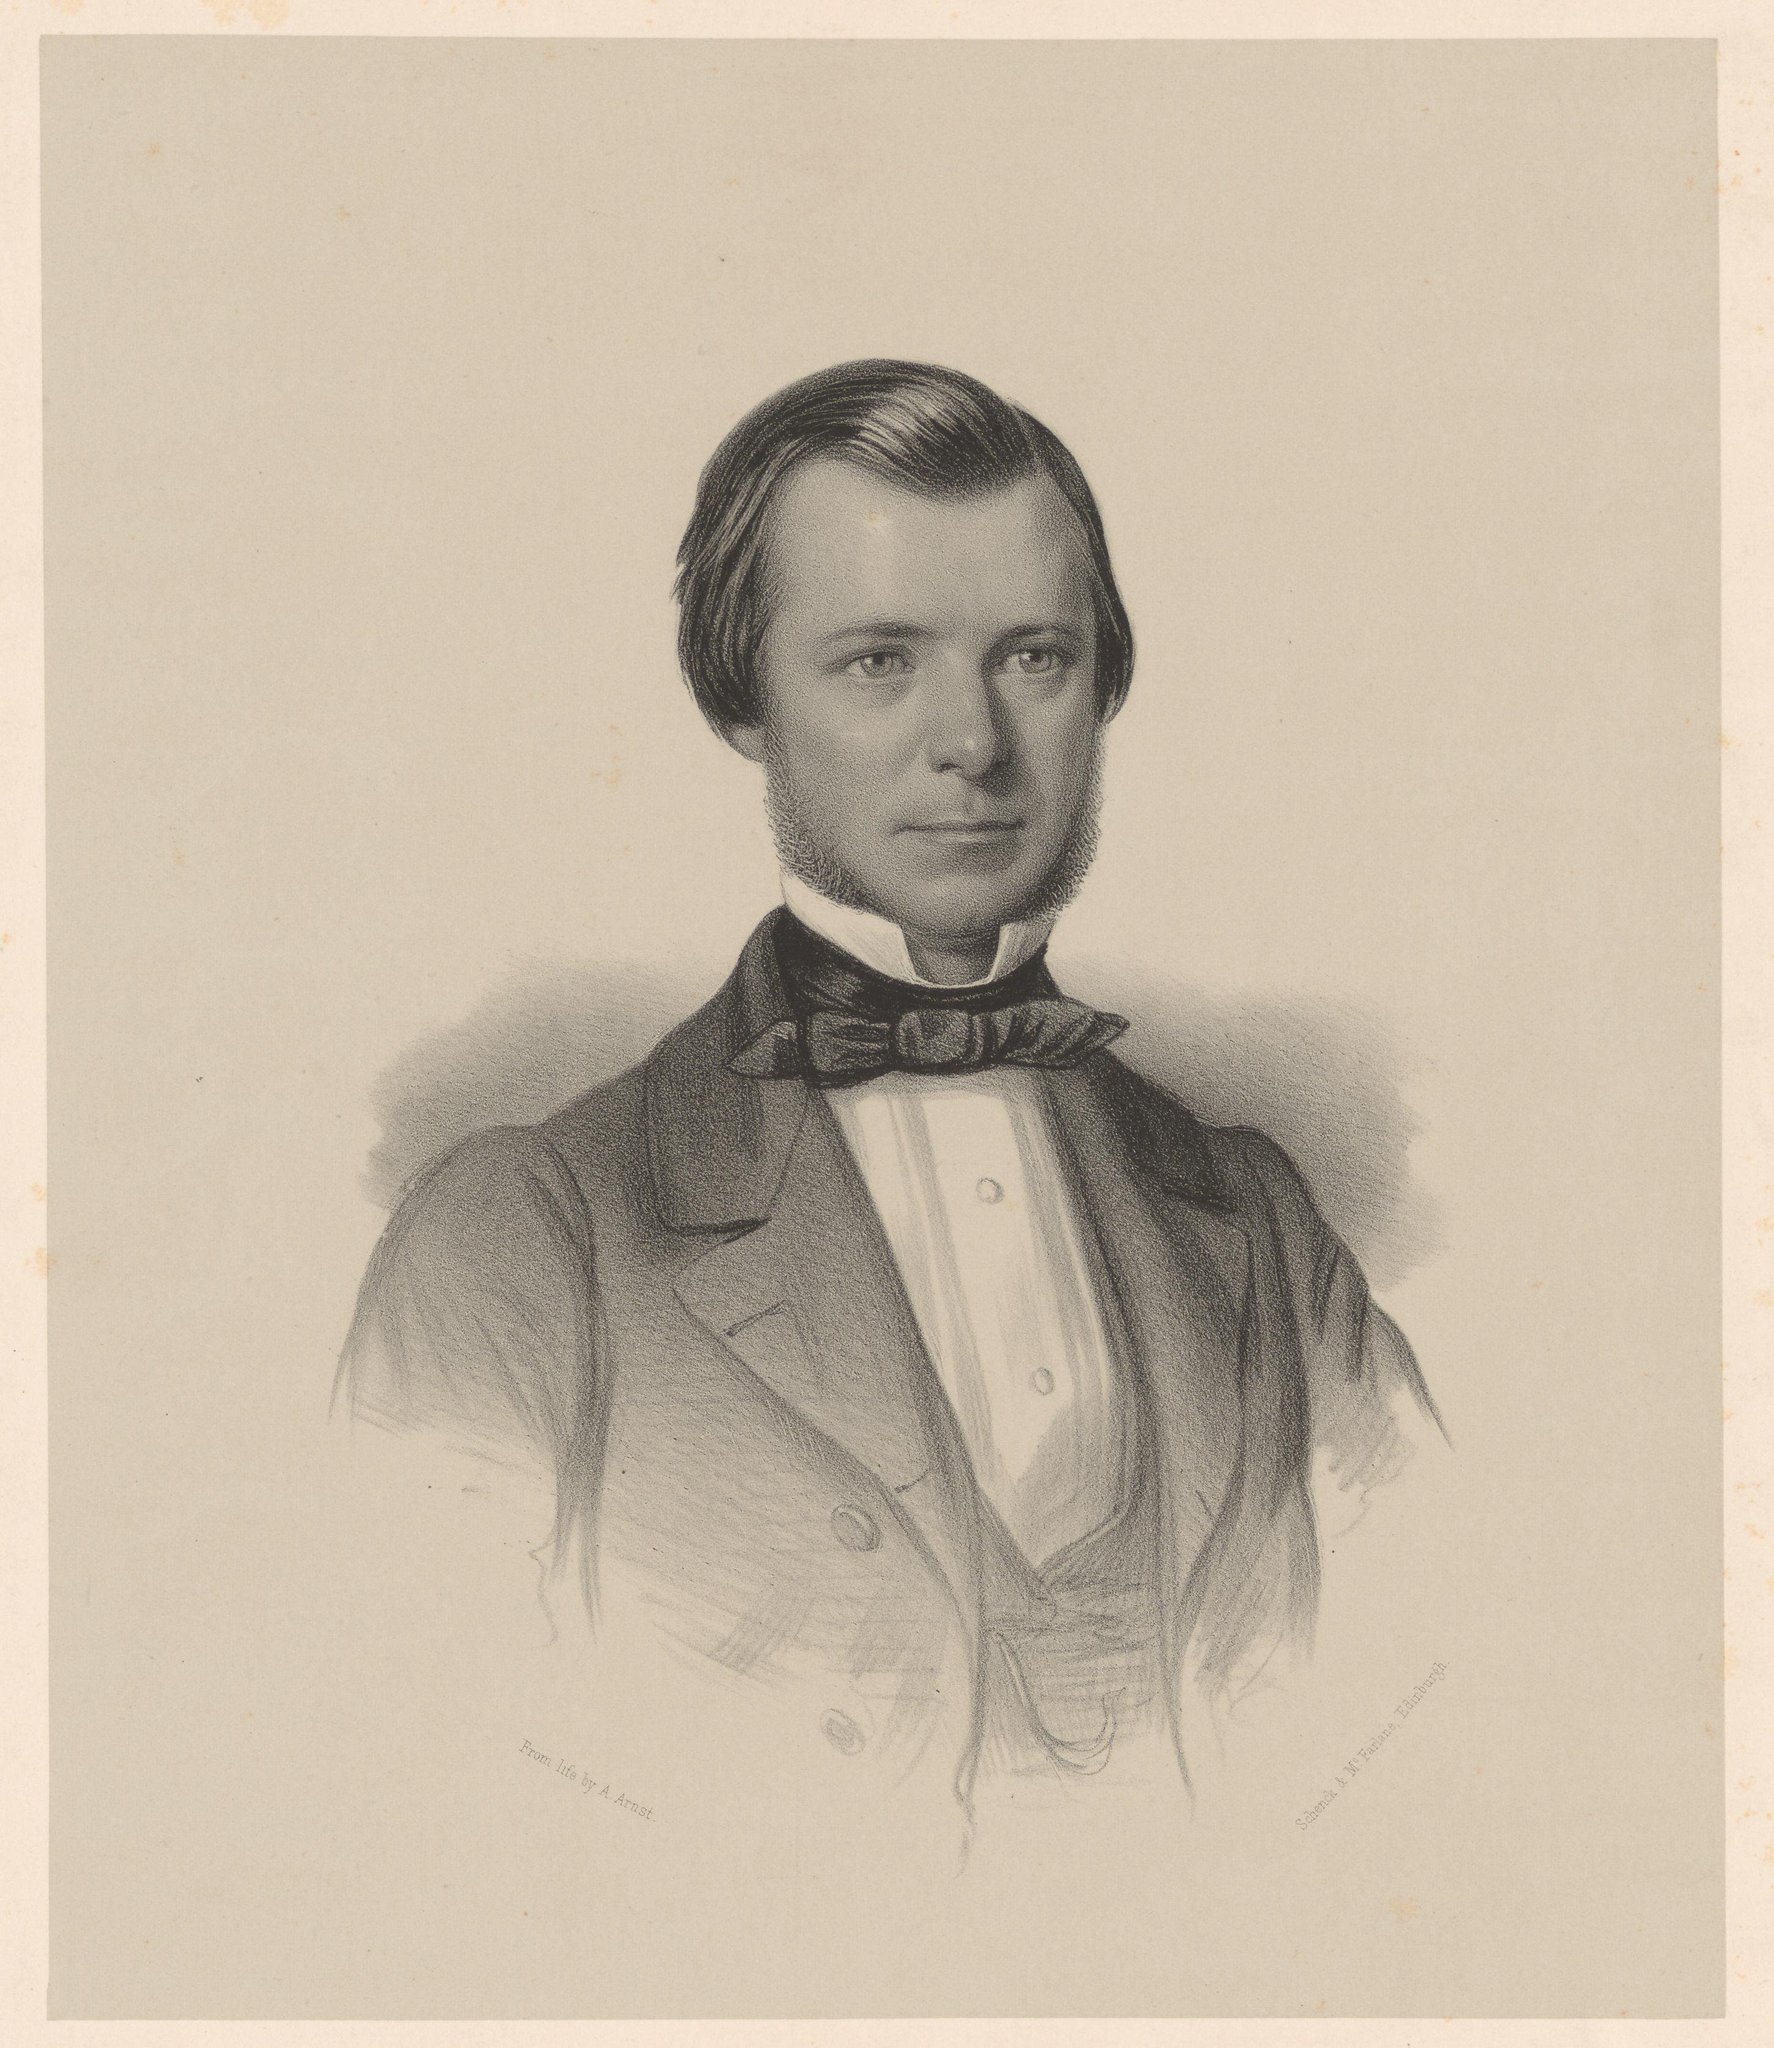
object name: print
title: Portret van een onbekende man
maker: a. arnst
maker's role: print maker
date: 1830-1870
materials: paper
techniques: lithograph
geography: edinburgh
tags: adult man, historical persons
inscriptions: collector's mark: Lugt 2228